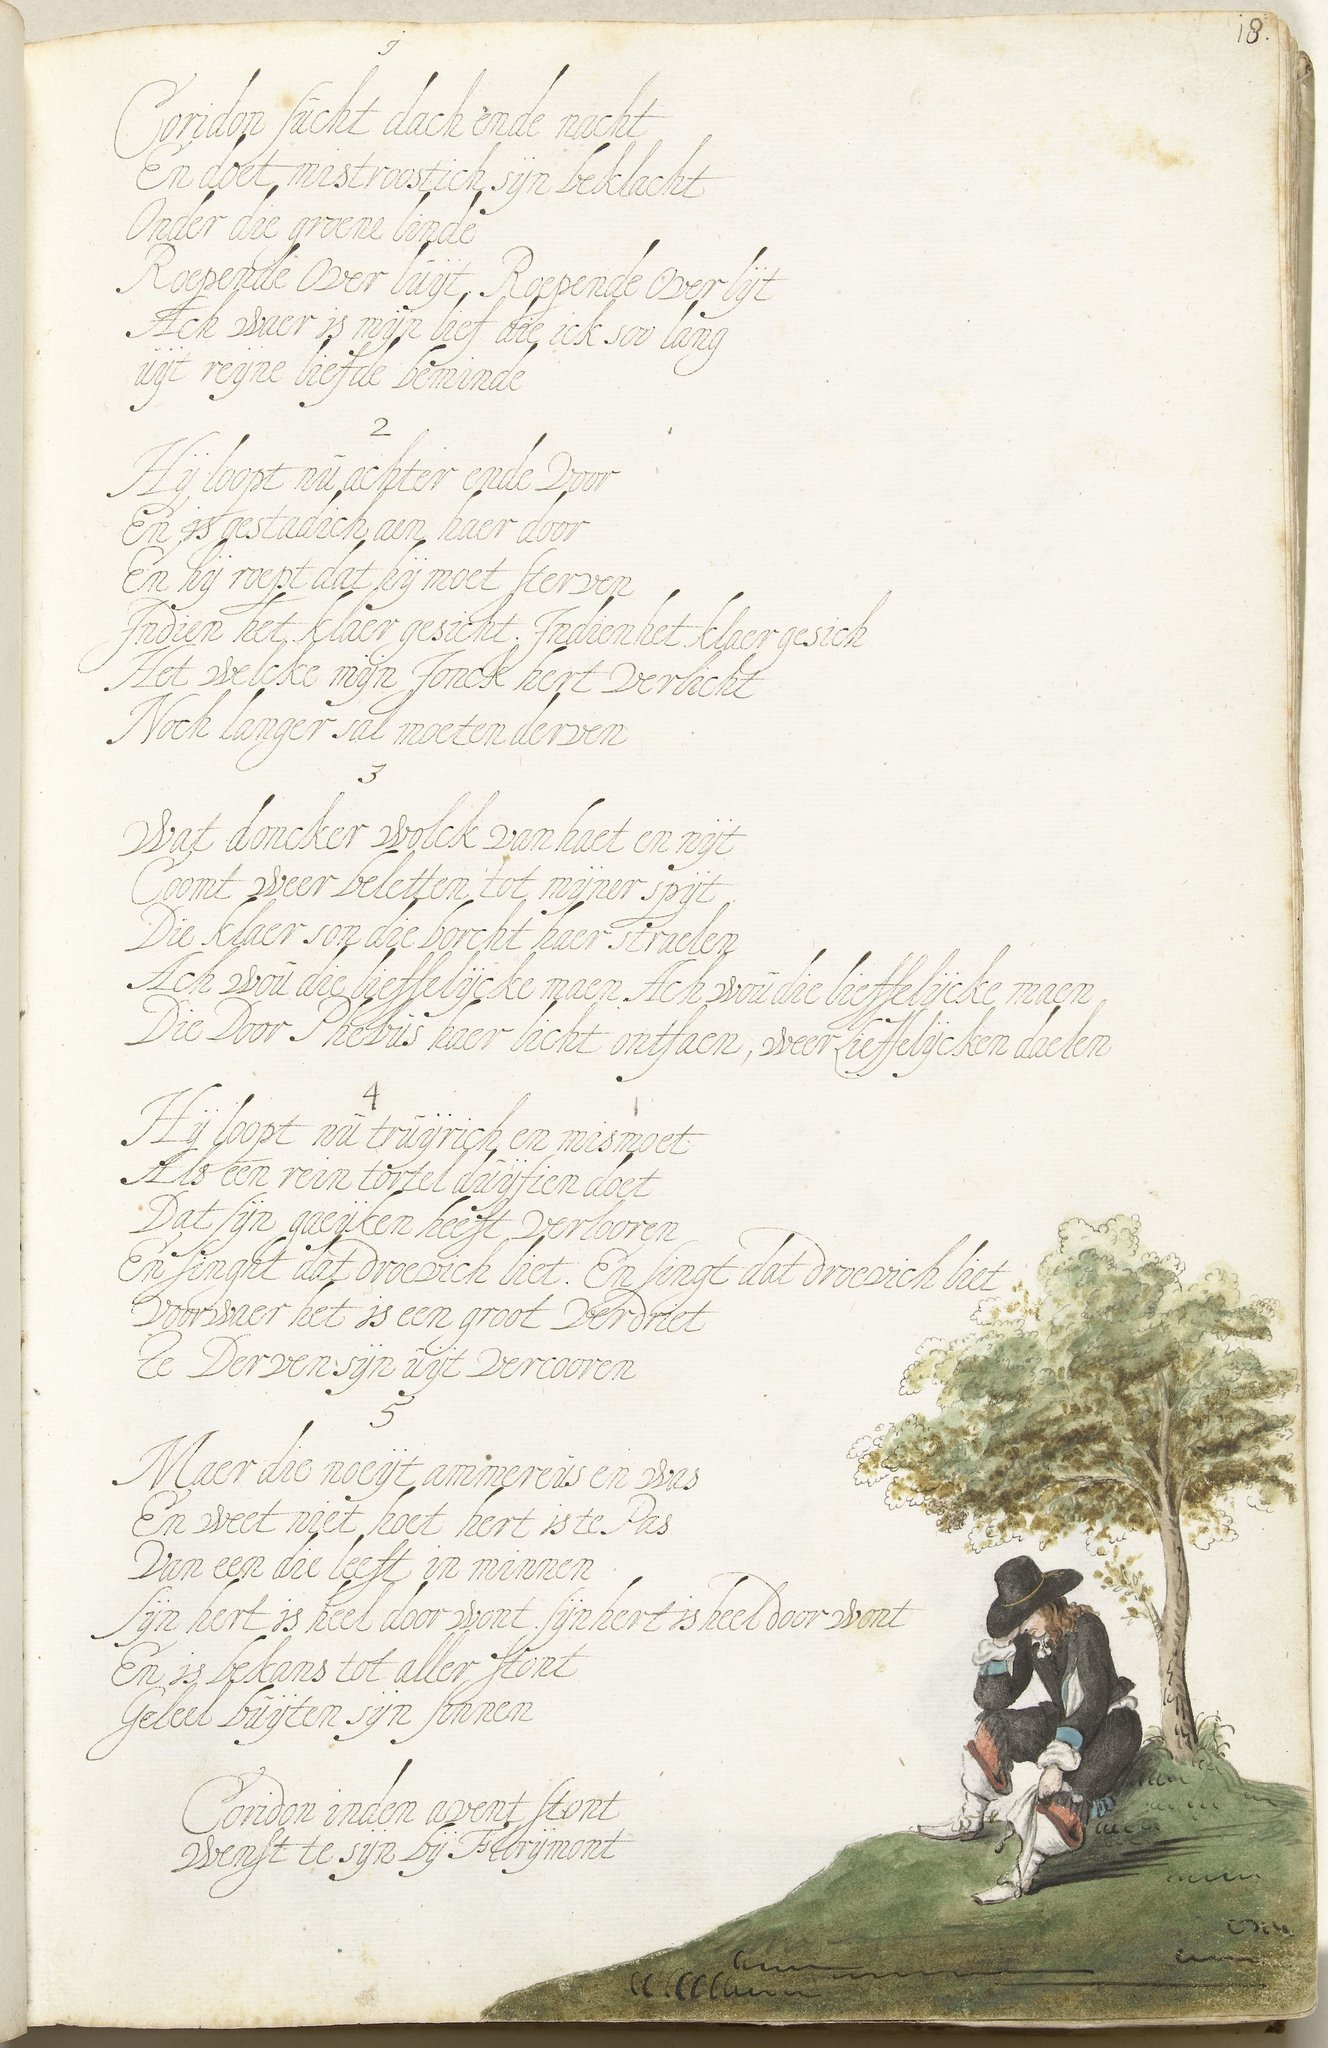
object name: drawing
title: Melancholische aanbidder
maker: gesina ter borch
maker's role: draughtsman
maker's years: 1633-1690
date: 1652-1653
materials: ink, paper, watercolor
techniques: brush, calligraphy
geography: zwolle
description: Het gedicht stond in Het Brabandts Nachtegaelken, uitgegeven in 1656, met verschillen in spelling en woordkeuze. Aangezien Gesina het gedicht zeker voor 1656 gekopieerd heeft was het klaarblijkelijk al in omloop voor die publicatiedatum.